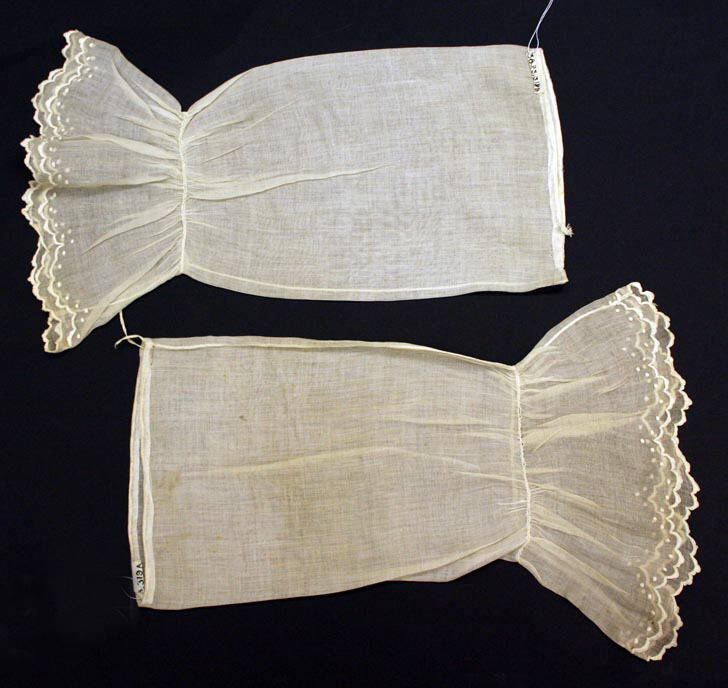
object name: sleeve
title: Sleeves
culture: european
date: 1770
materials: cotton